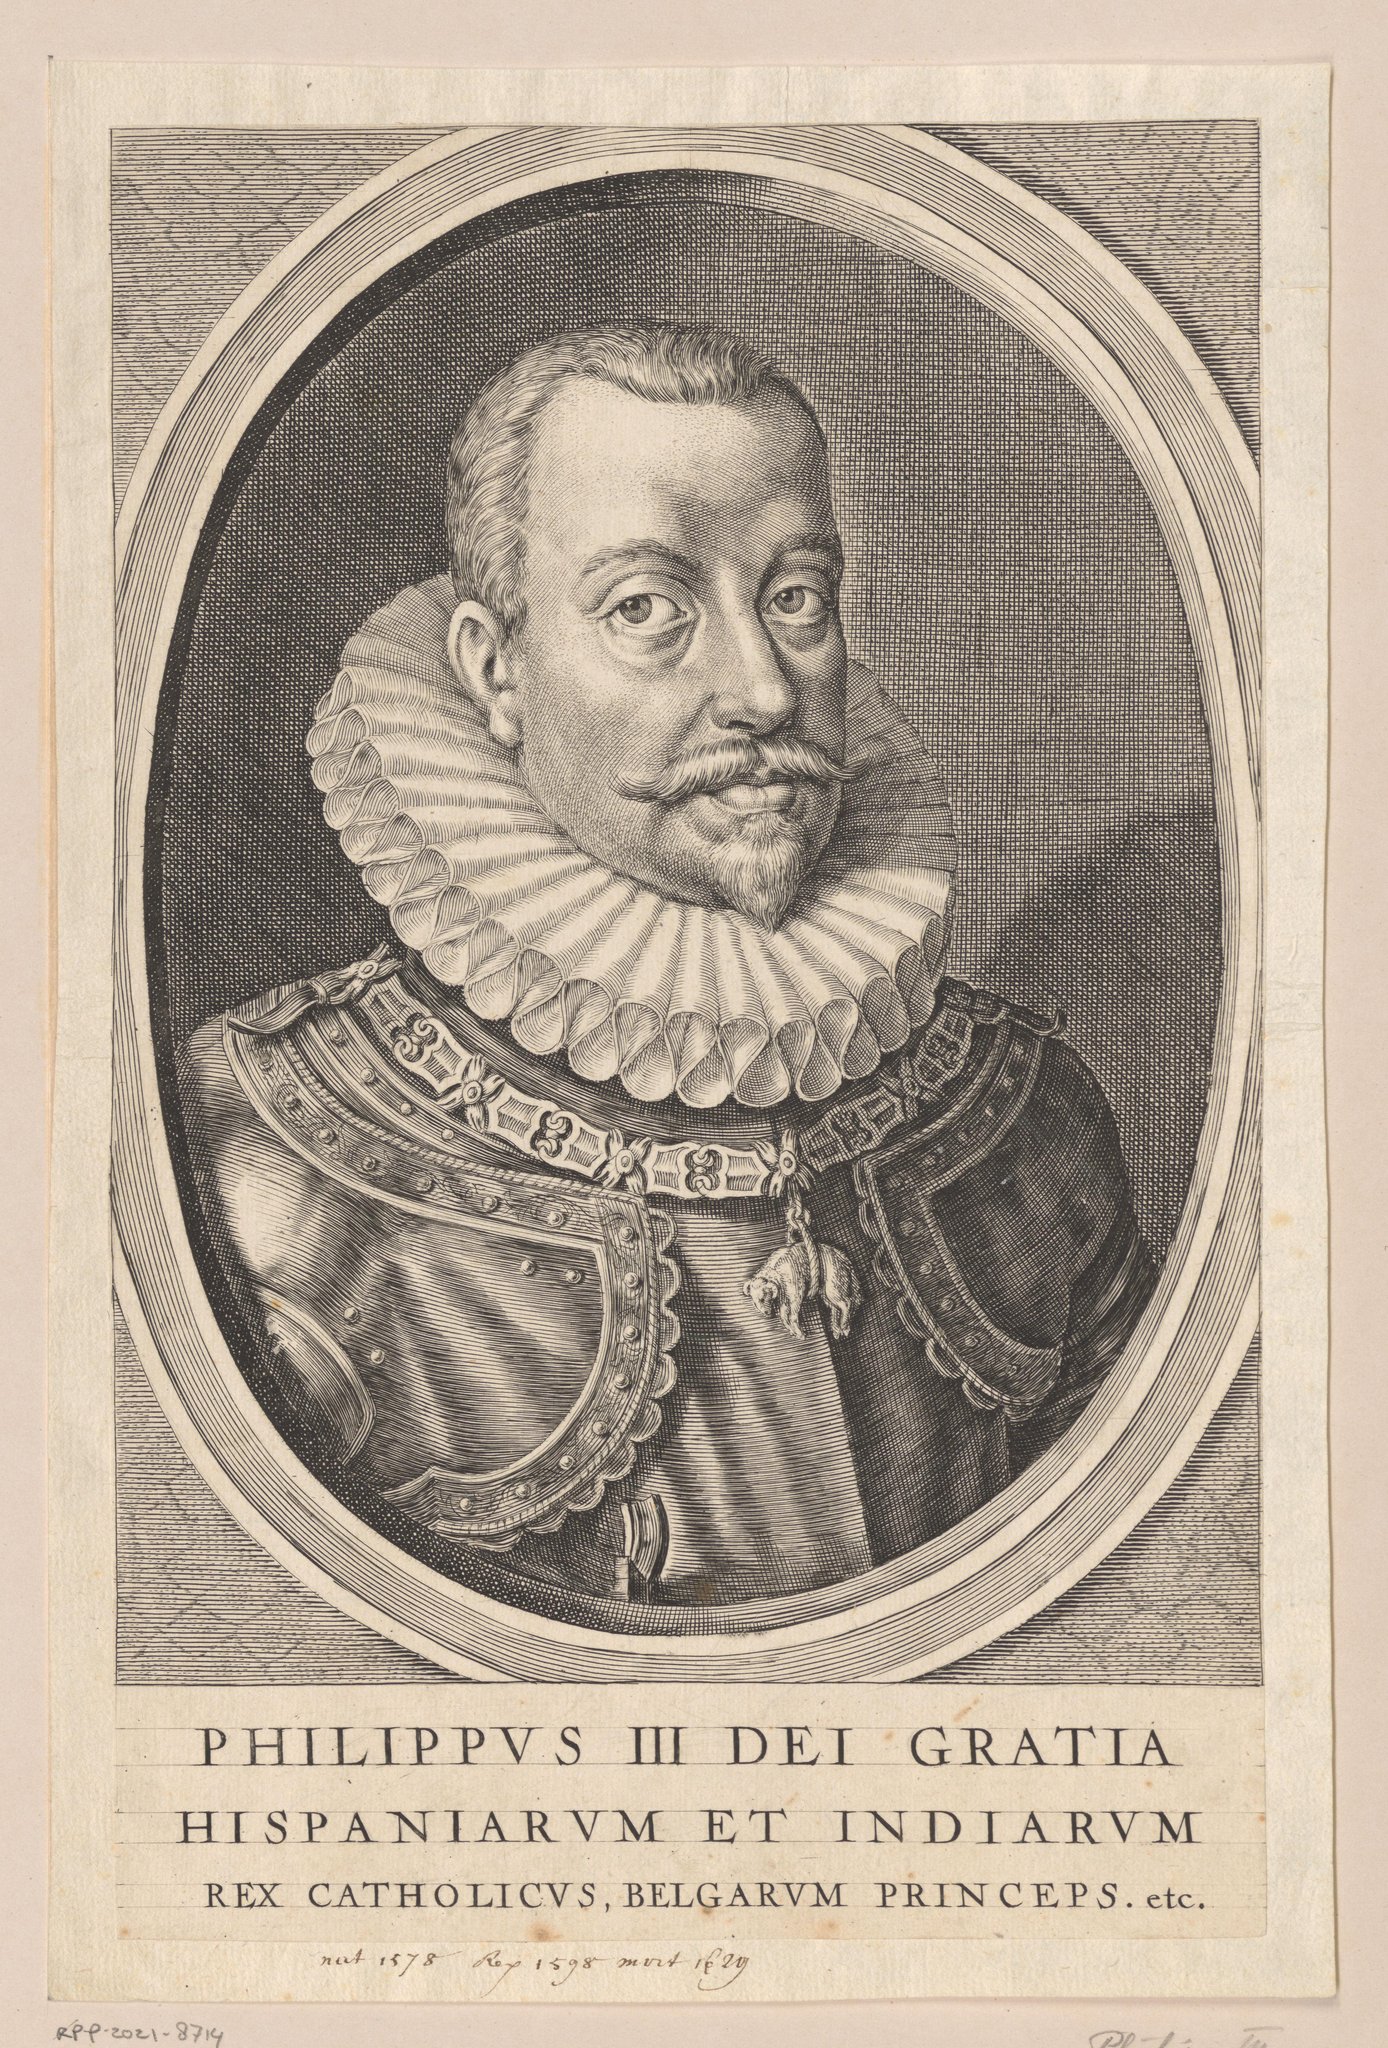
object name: print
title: Portret van Filips III, koning van Spanje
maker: Anonymous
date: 1647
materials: paper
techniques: engraving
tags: filips iii (koning van spanje), adult man, historical persons, knighthood order of the golden fleece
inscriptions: inscription: ‘Nat 1578 eg 1598 mort 162[9]’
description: Prent mogelijk uit: Meteren, Emanuel van. Historien der Nederlanden, en haar naburen oorlogen tot het jaar 1612. Zaandam: Hendrick Jacobsz. Zoet, 1647.